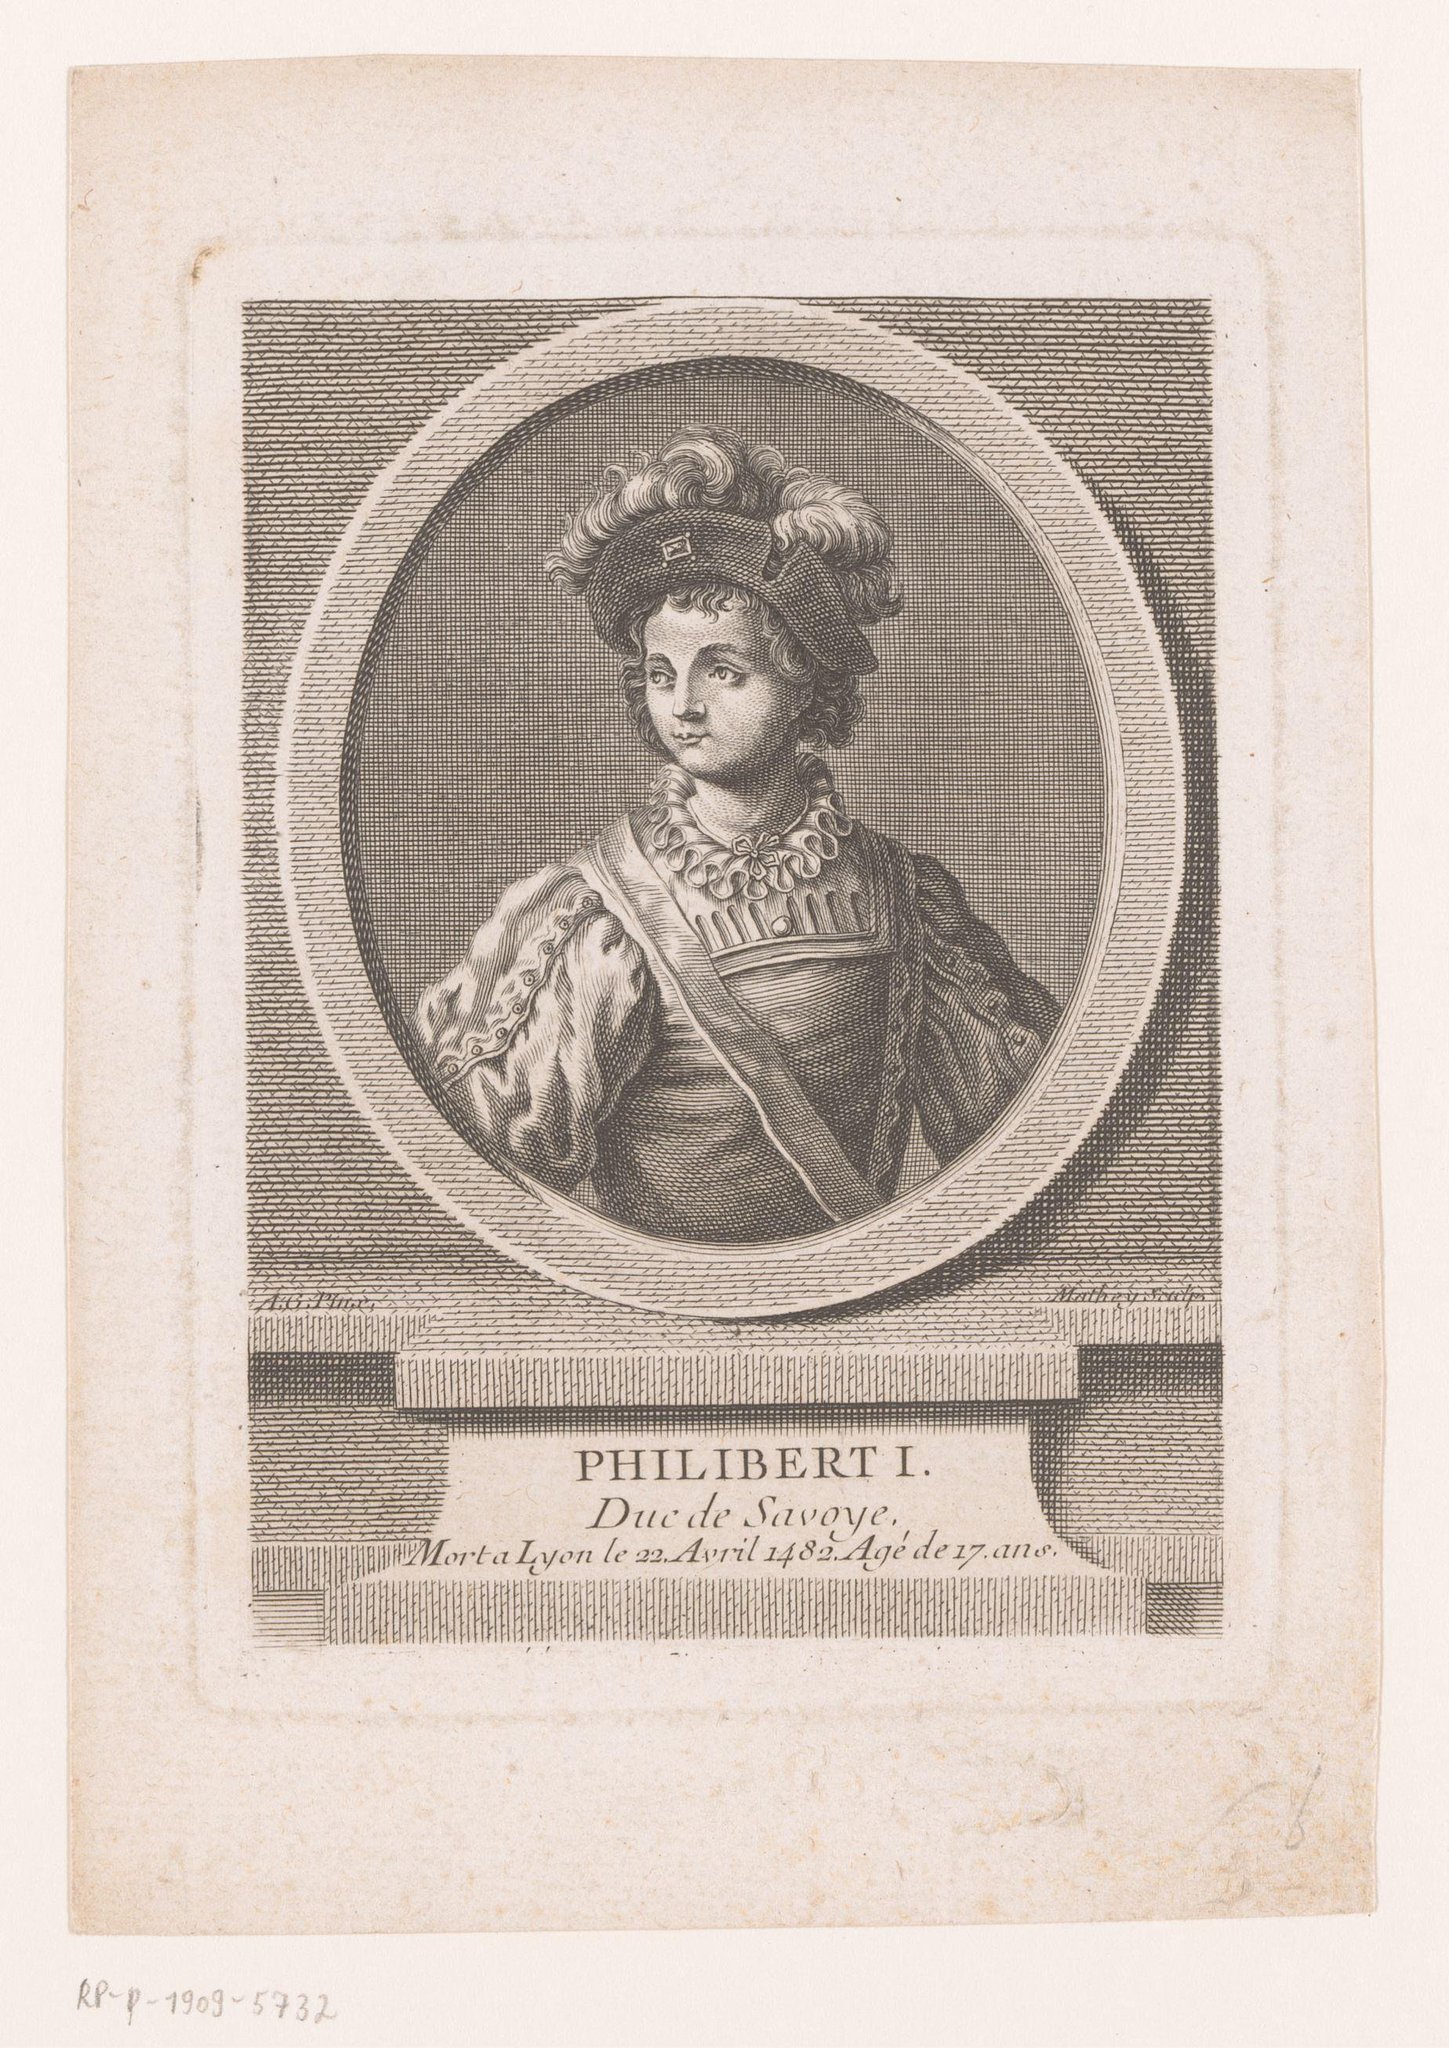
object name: print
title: Portret van Filibert I van Savoye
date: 1755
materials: paper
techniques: engraving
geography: france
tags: lyon, historical persons, nobility and patriciate; chivalry, knighthood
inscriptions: collector's mark: Lugt 2228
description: Mogelijk prent uit: Dreux du Radier, Jean-François. L'Europe illustré, contenant l'histoire abregée des souverains, des princes, des prélats, des ministres, (...) en Europe: dans le XVe. siècle compris, jusqu'à présent. Parijs: Michel Odieuvre en Jean-Luc Nyon, ca. 1755.